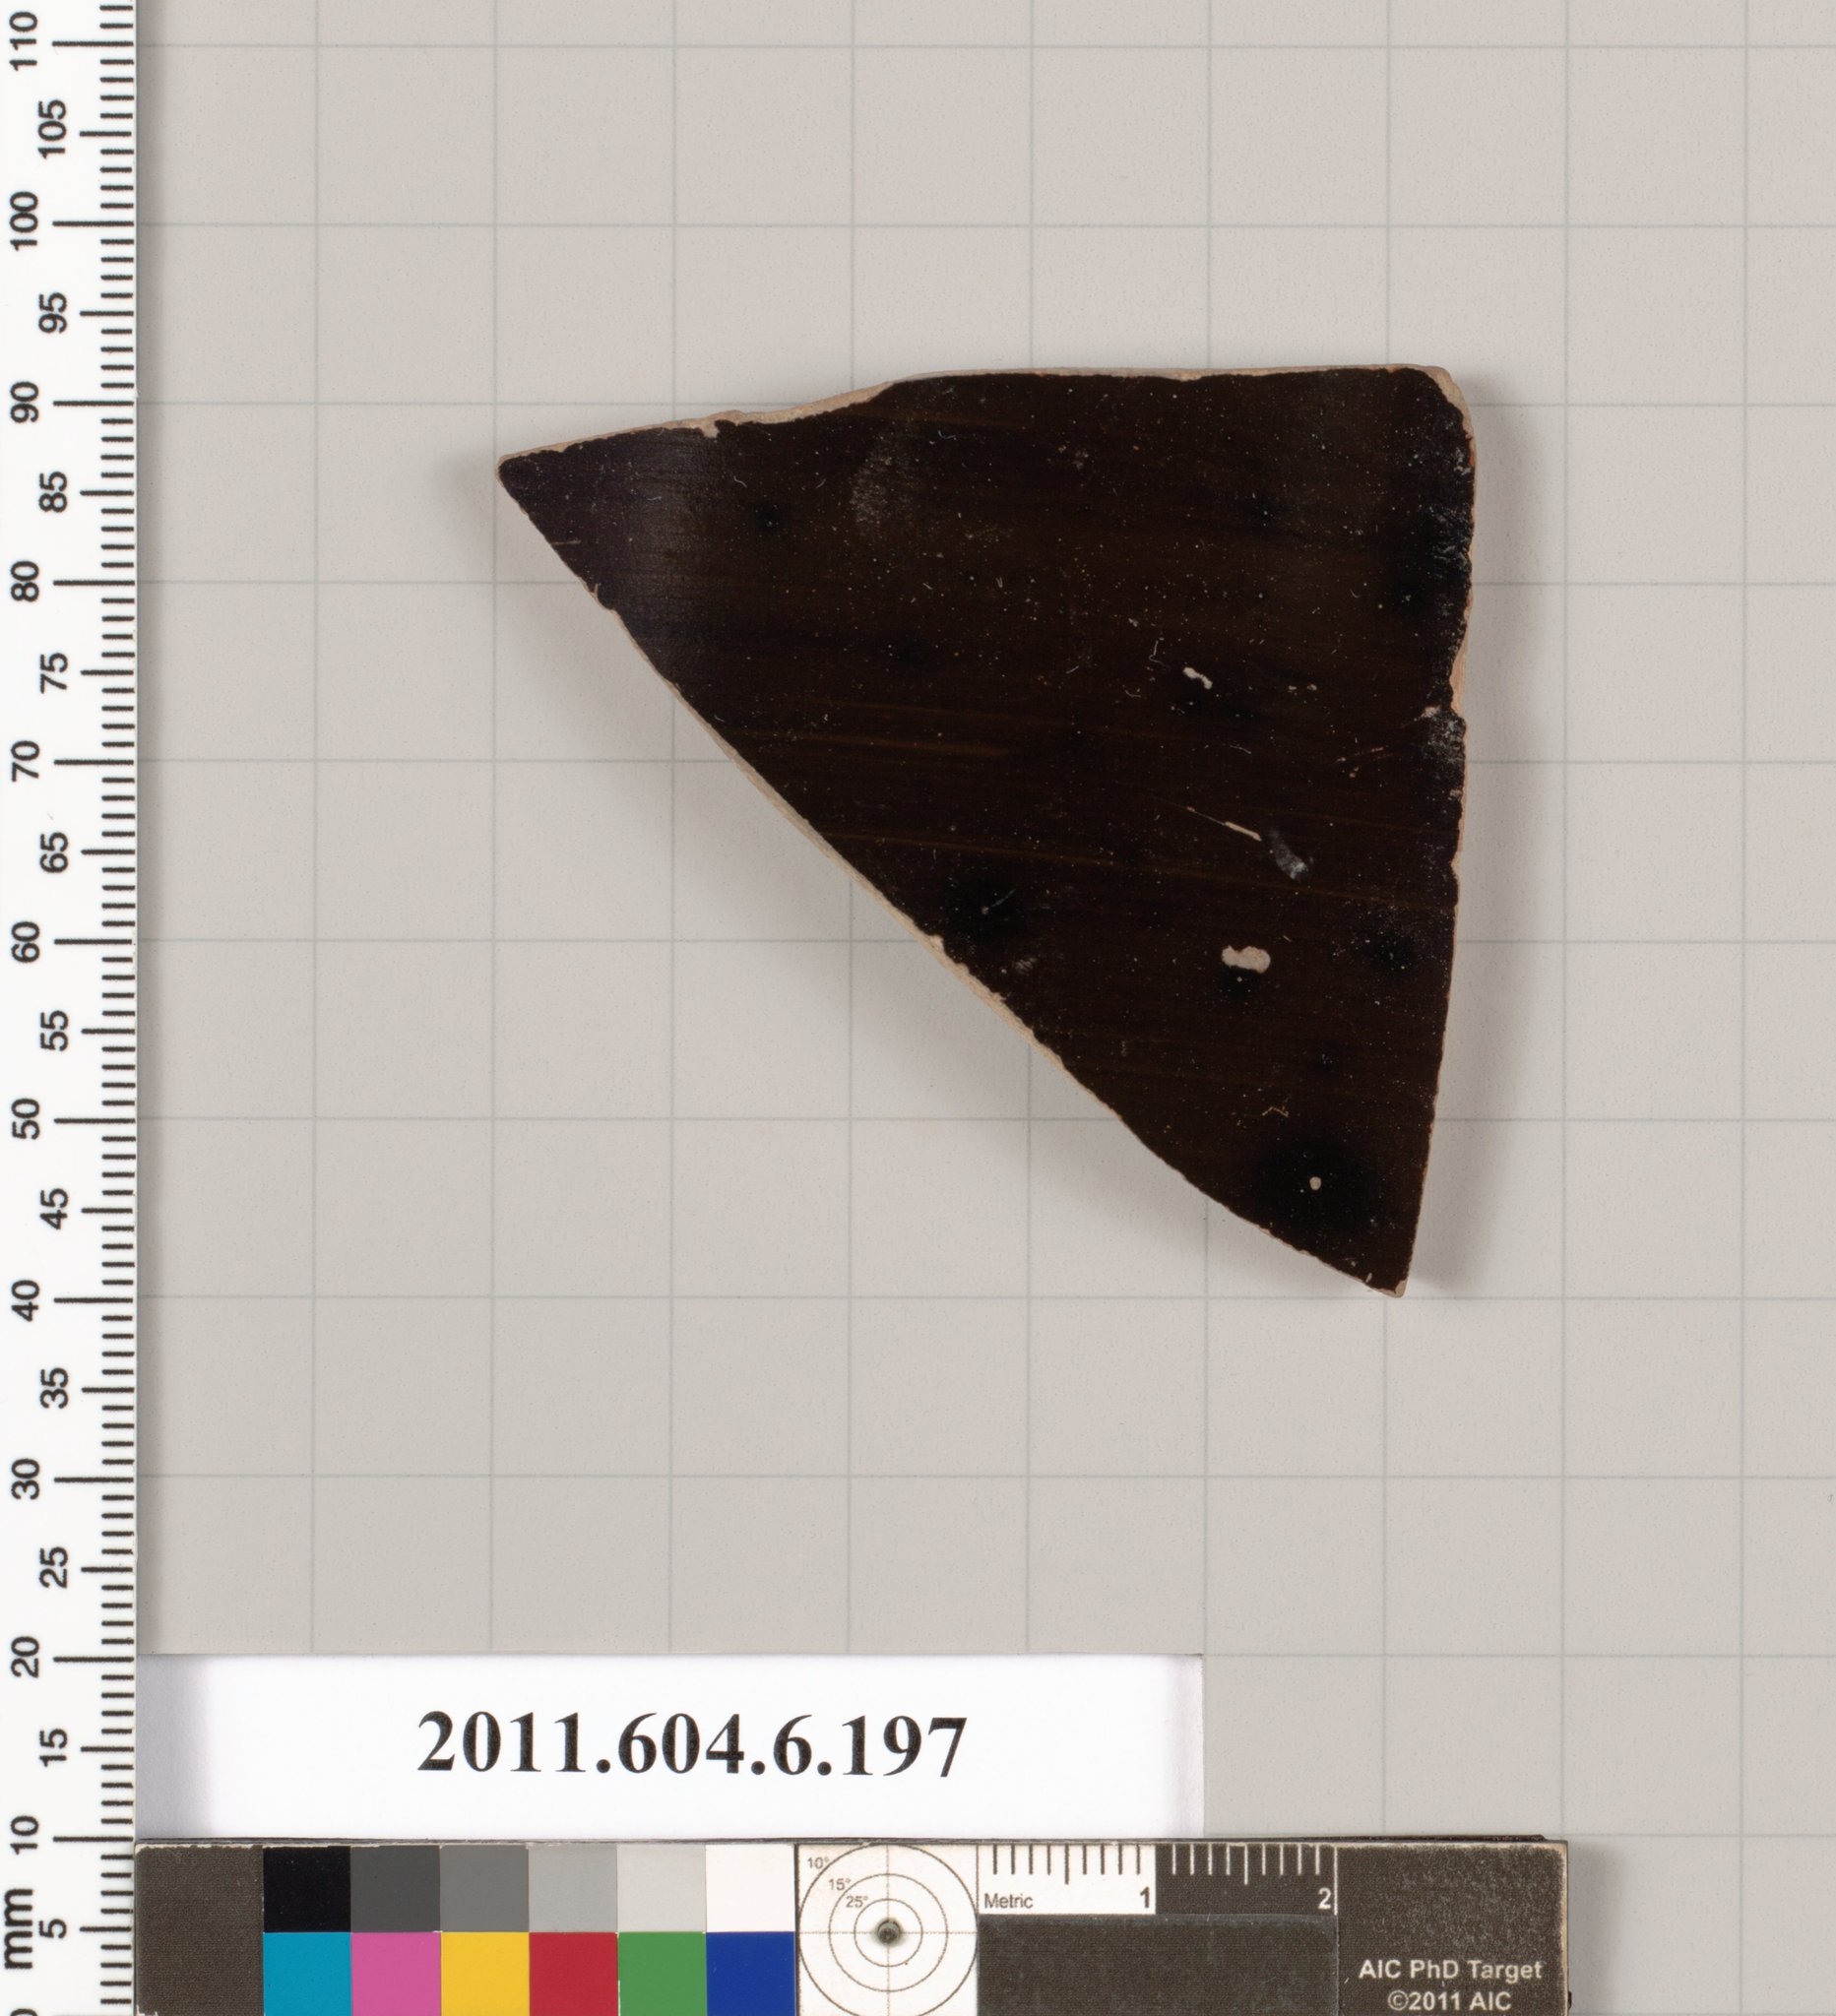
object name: skyphos fragment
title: Terracotta fragment of a skyphos (deep drinking cup)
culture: greek, attic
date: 500-401 BCE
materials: terracotta